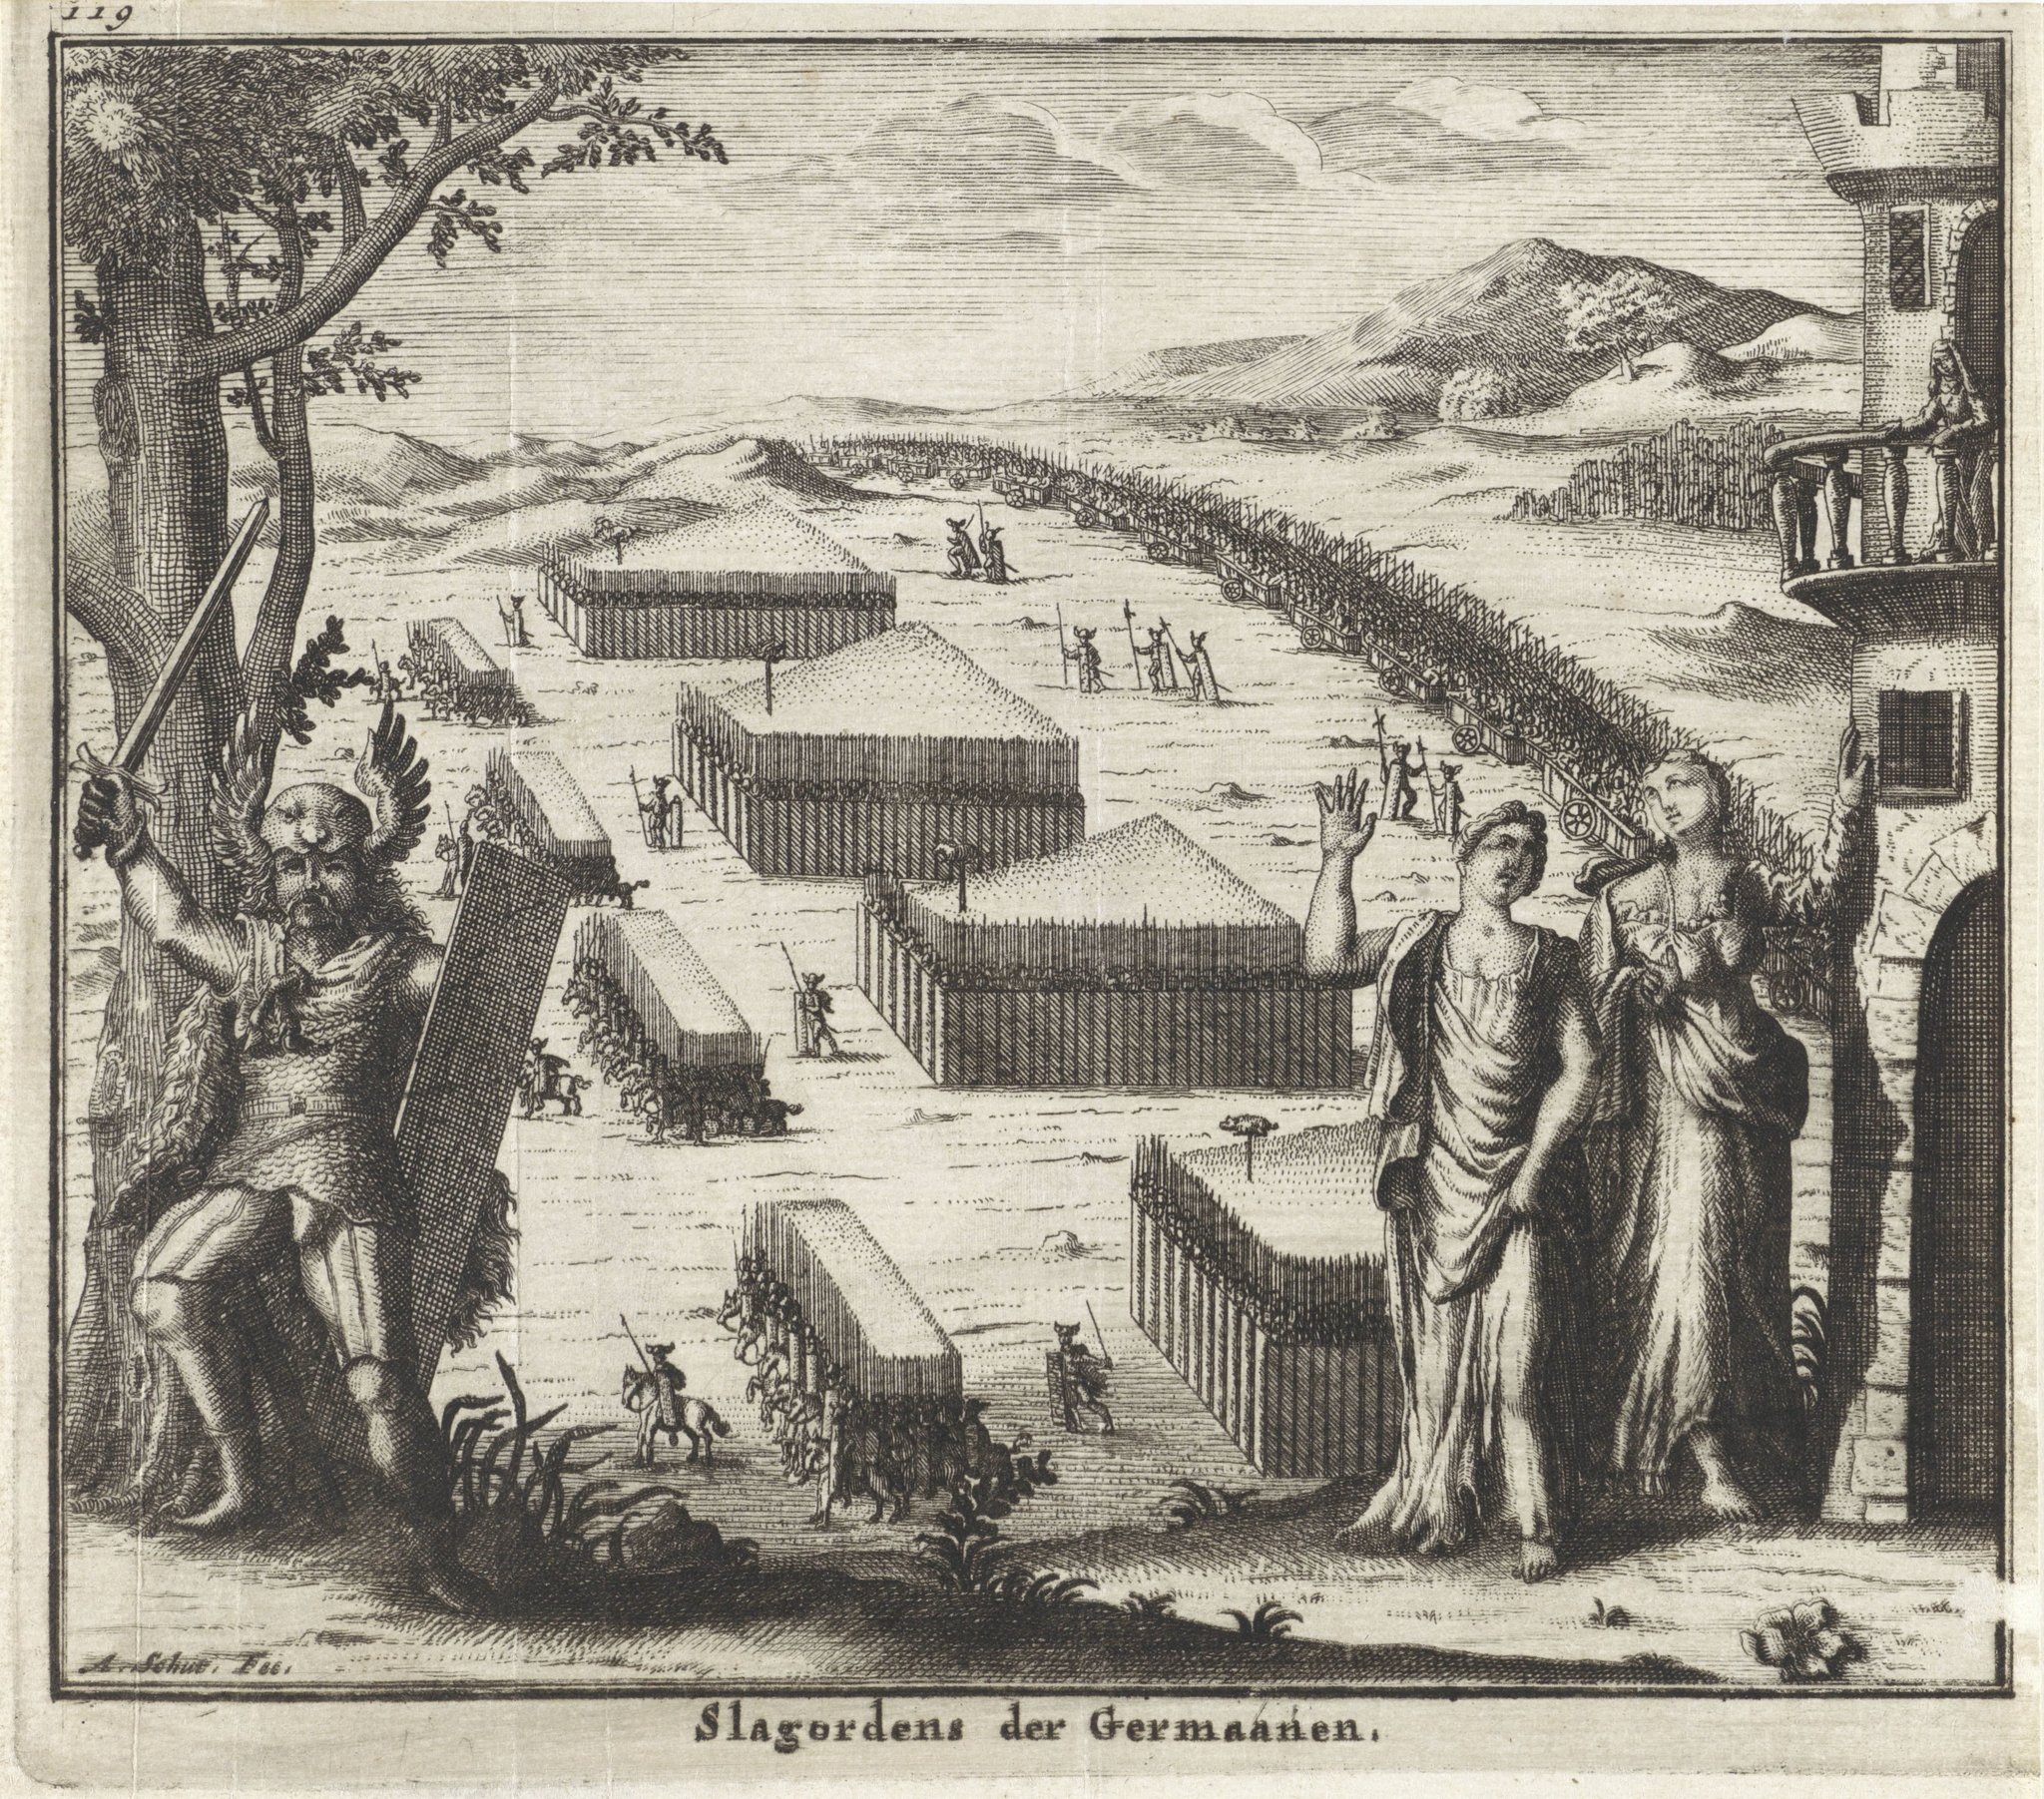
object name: book illustration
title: Germaanse legereenheden op het slagveld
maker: albert schut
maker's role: print maker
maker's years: 1687-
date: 1708-1713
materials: paper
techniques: engraving, etching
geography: amsterdam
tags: marching away (troops), extinct, 'historical' peoples (with name)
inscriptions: collector's mark: Lugt 2228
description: Het voetvolk en de ruiters van het Germaanse leger marcheren in grote vierkante en rechthoekige eenheden over een veld. Op de voorgrond een Germaanse krijger bij een boom en twee wenende vrouwen bij een toren. Linksboven genummerd: 119.